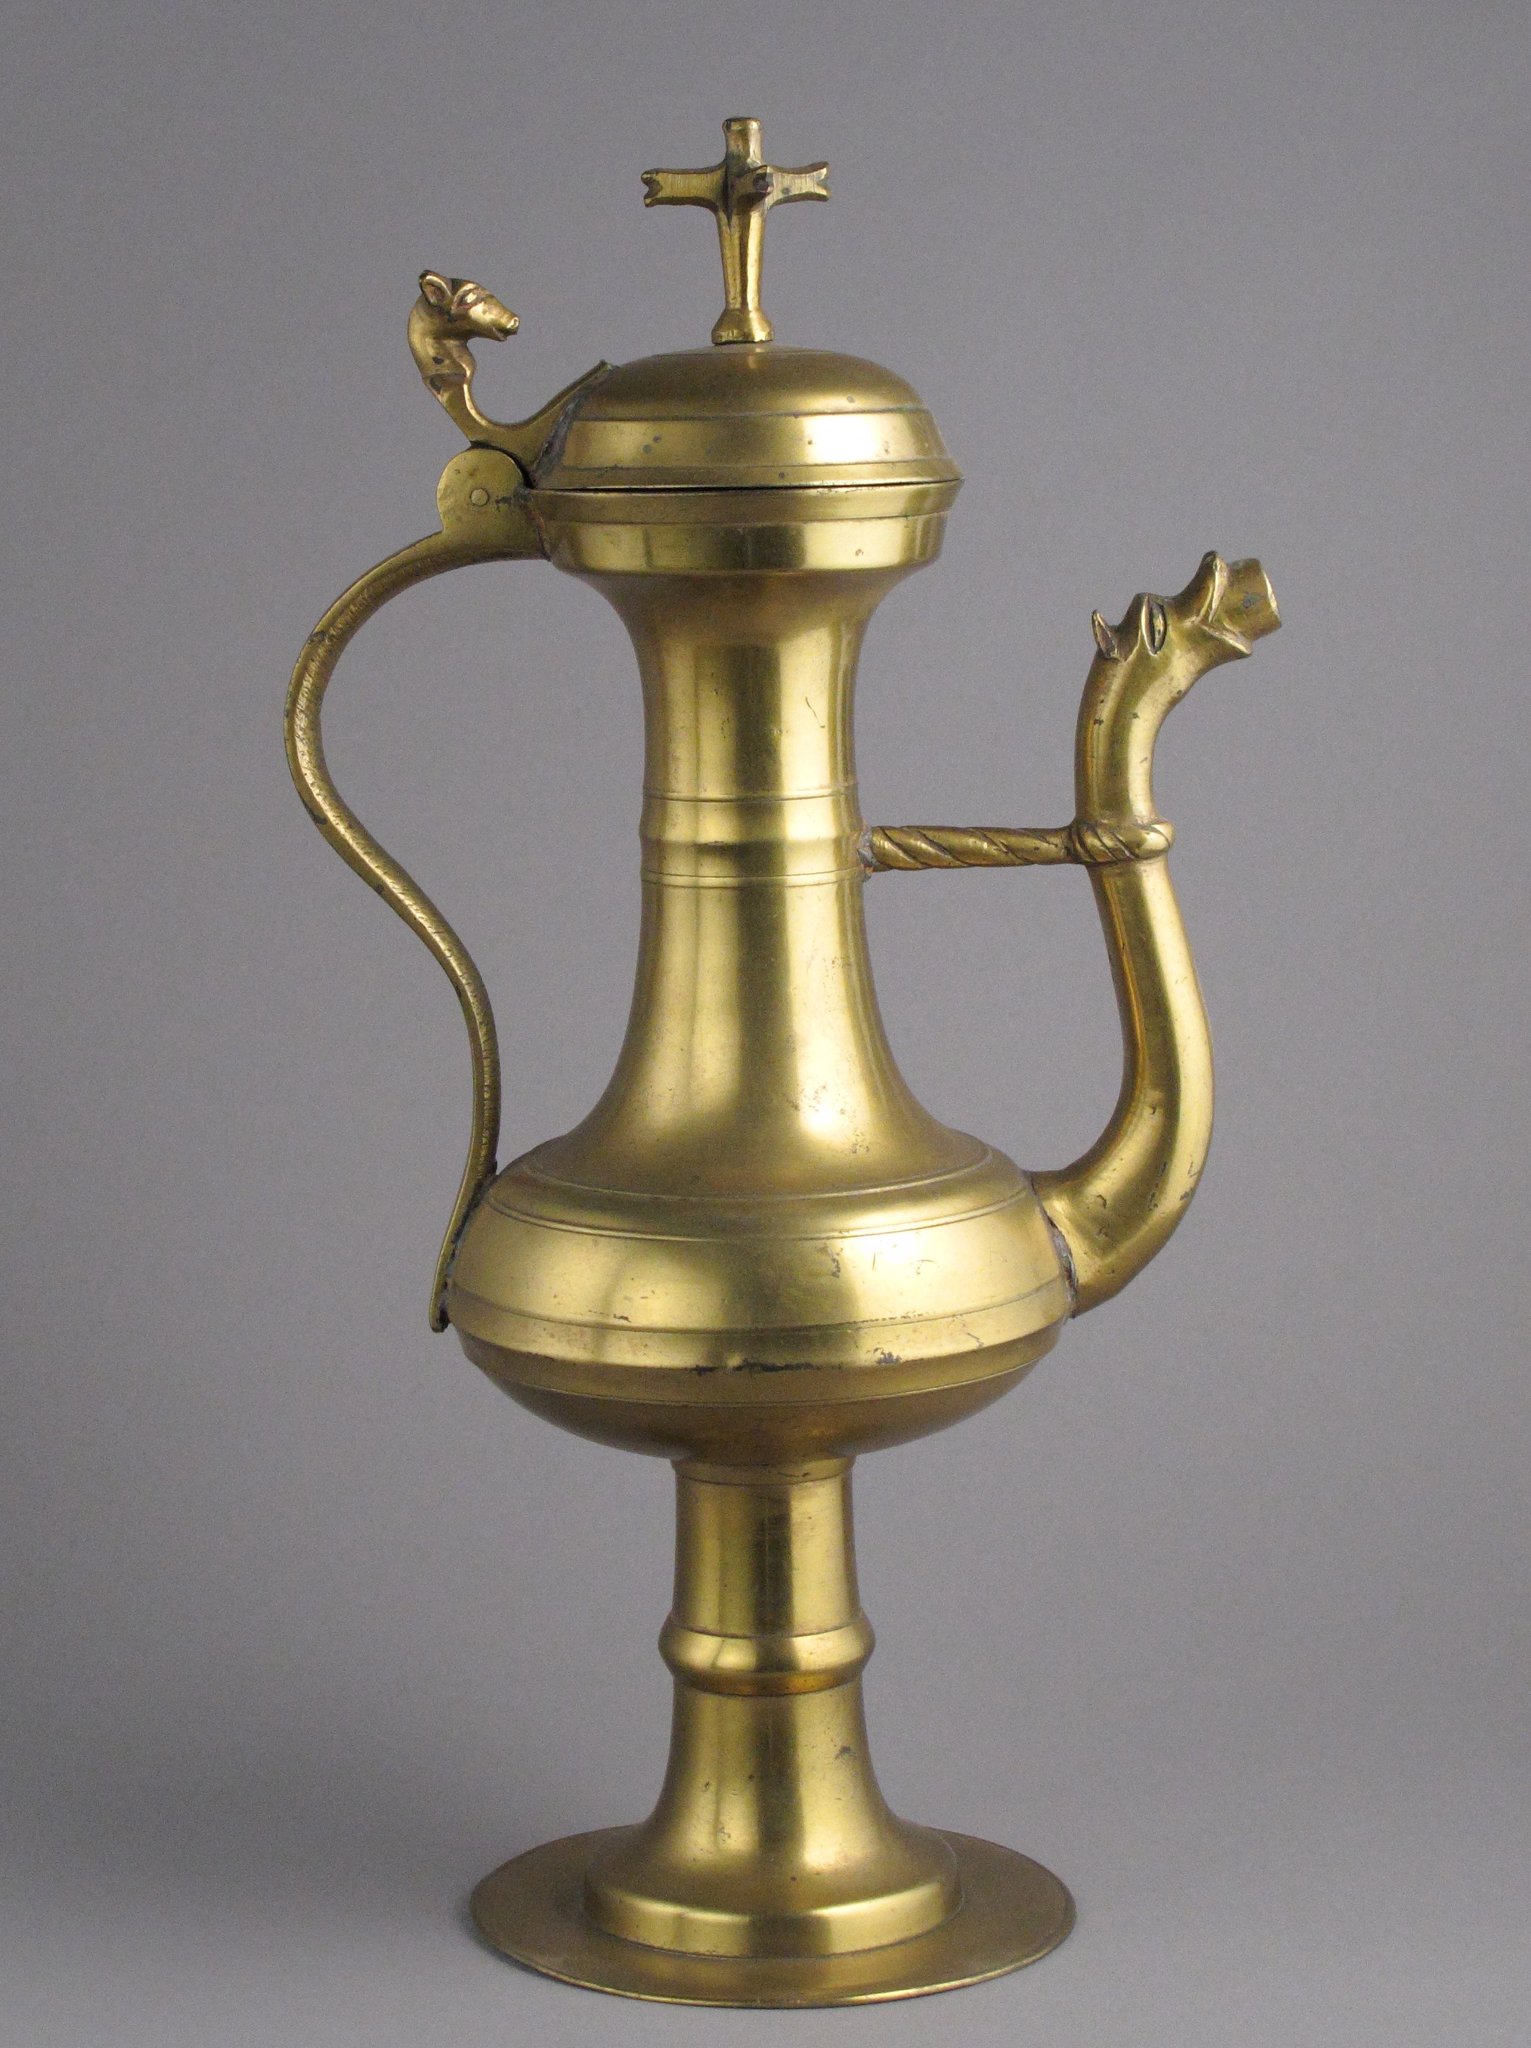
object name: ewer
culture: german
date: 1401-1500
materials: copper alloy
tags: cross